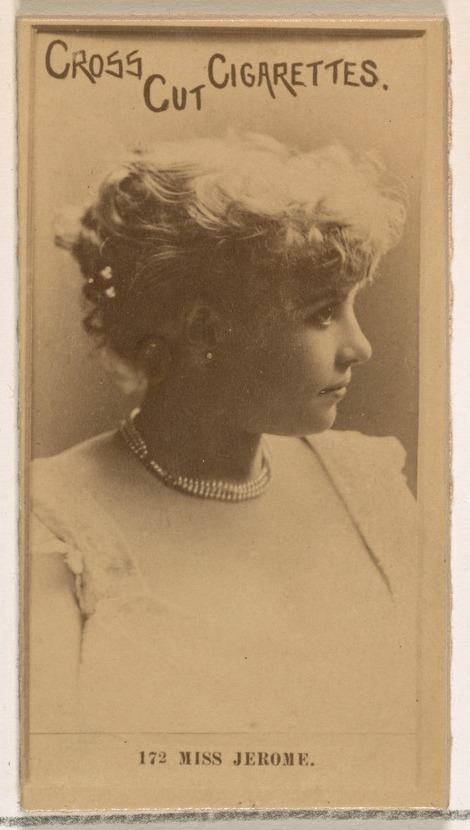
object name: print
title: Card Number 172, Miss Jerome, from the Actors and Actresses series (N145-2) issued by Duke Sons & Co. to promote Cross Cut Cigarettes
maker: w. duke, sons & co.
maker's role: publisher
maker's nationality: american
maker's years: 1870-1920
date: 1880-1889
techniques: albumen silver print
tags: women,actresses